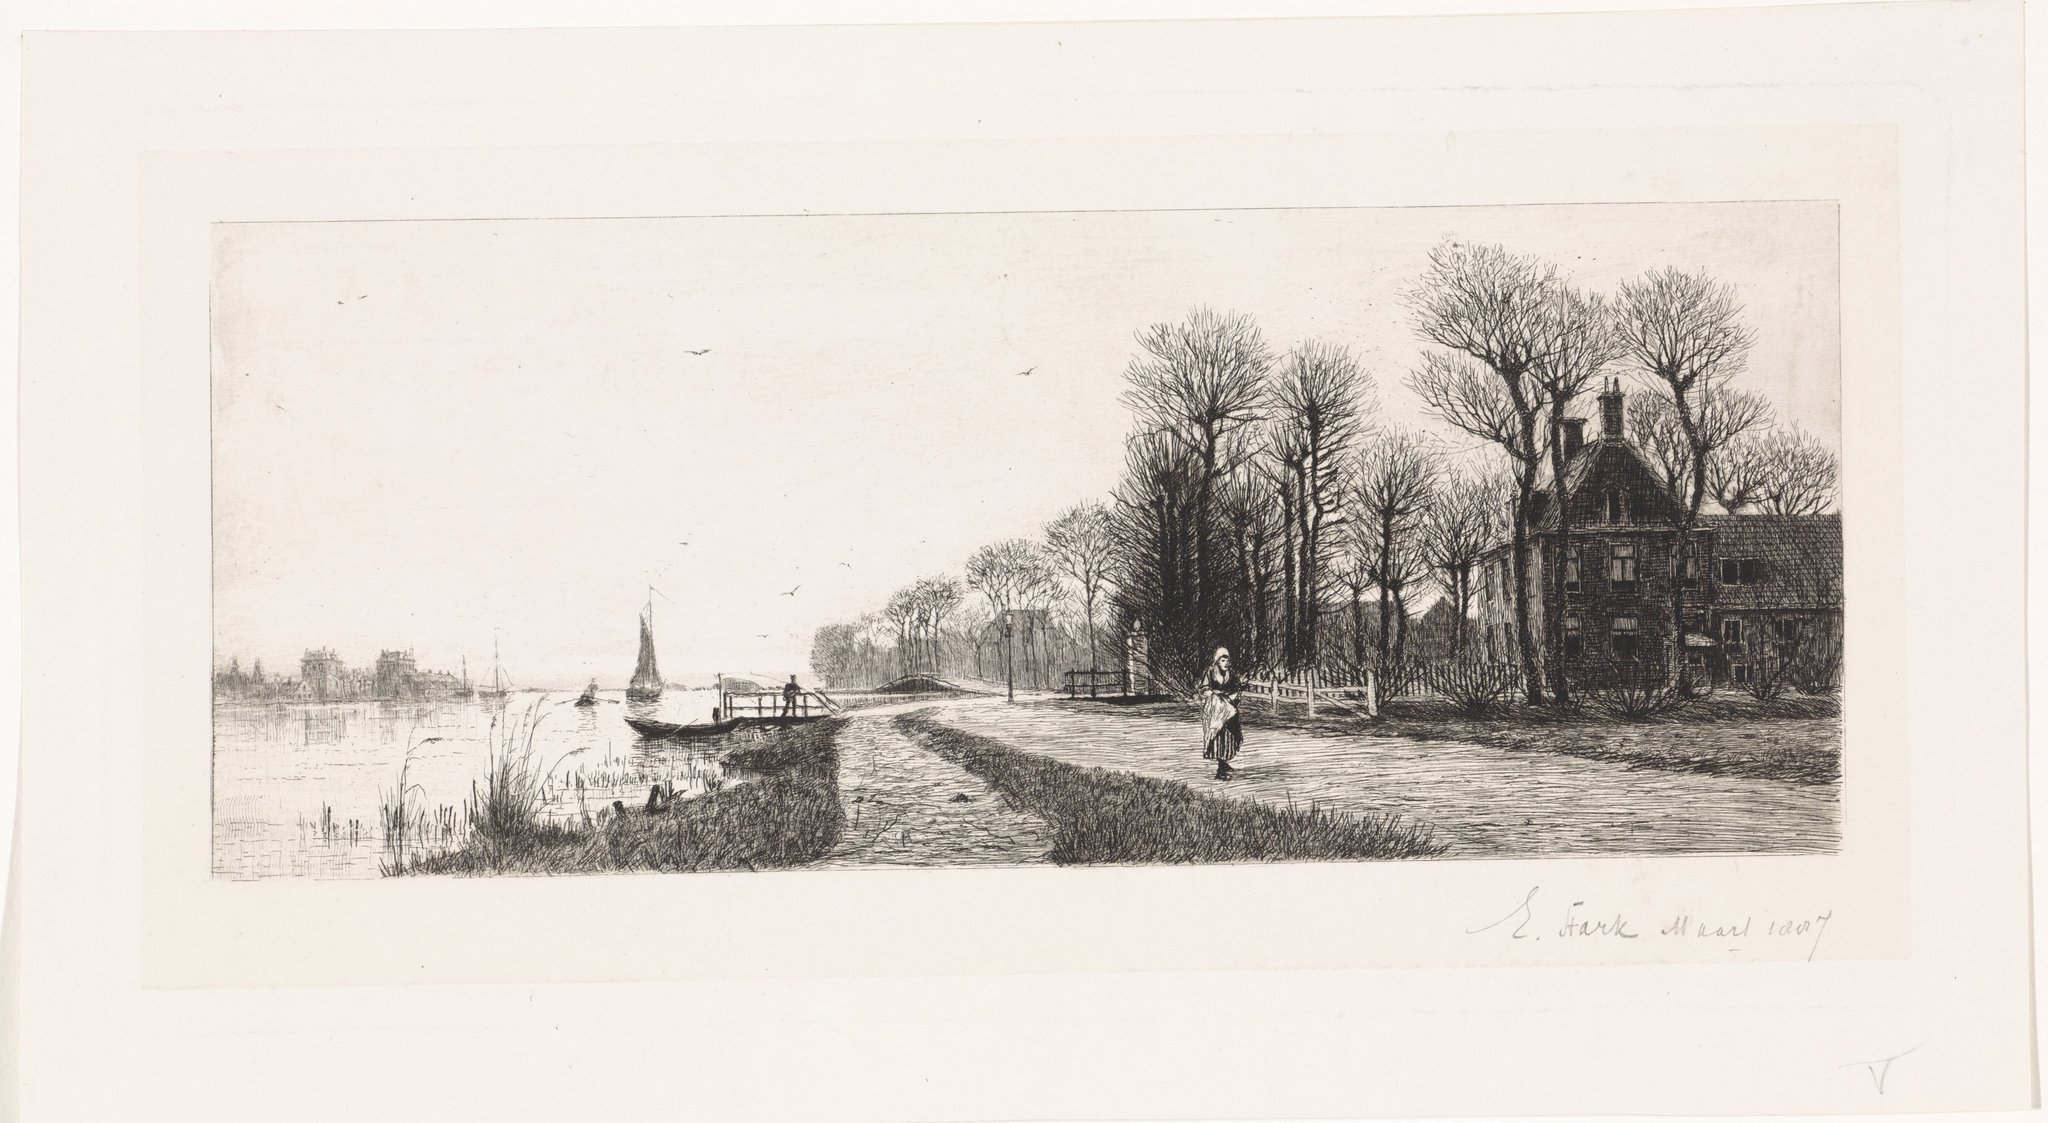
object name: print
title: Huizen aan de Amstel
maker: elias stark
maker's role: draughtsman, print maker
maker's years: 1849-1933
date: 1803-1887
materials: paper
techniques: aquatint, etching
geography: nieuwer-amstel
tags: river (+ landscape with figures, staffage)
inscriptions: signature: ‘E. Stark Maart 1887’, collector's mark: Lugt 2228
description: Huizen langs de rivier de Amstel. Op de weg loopt een vrouw.